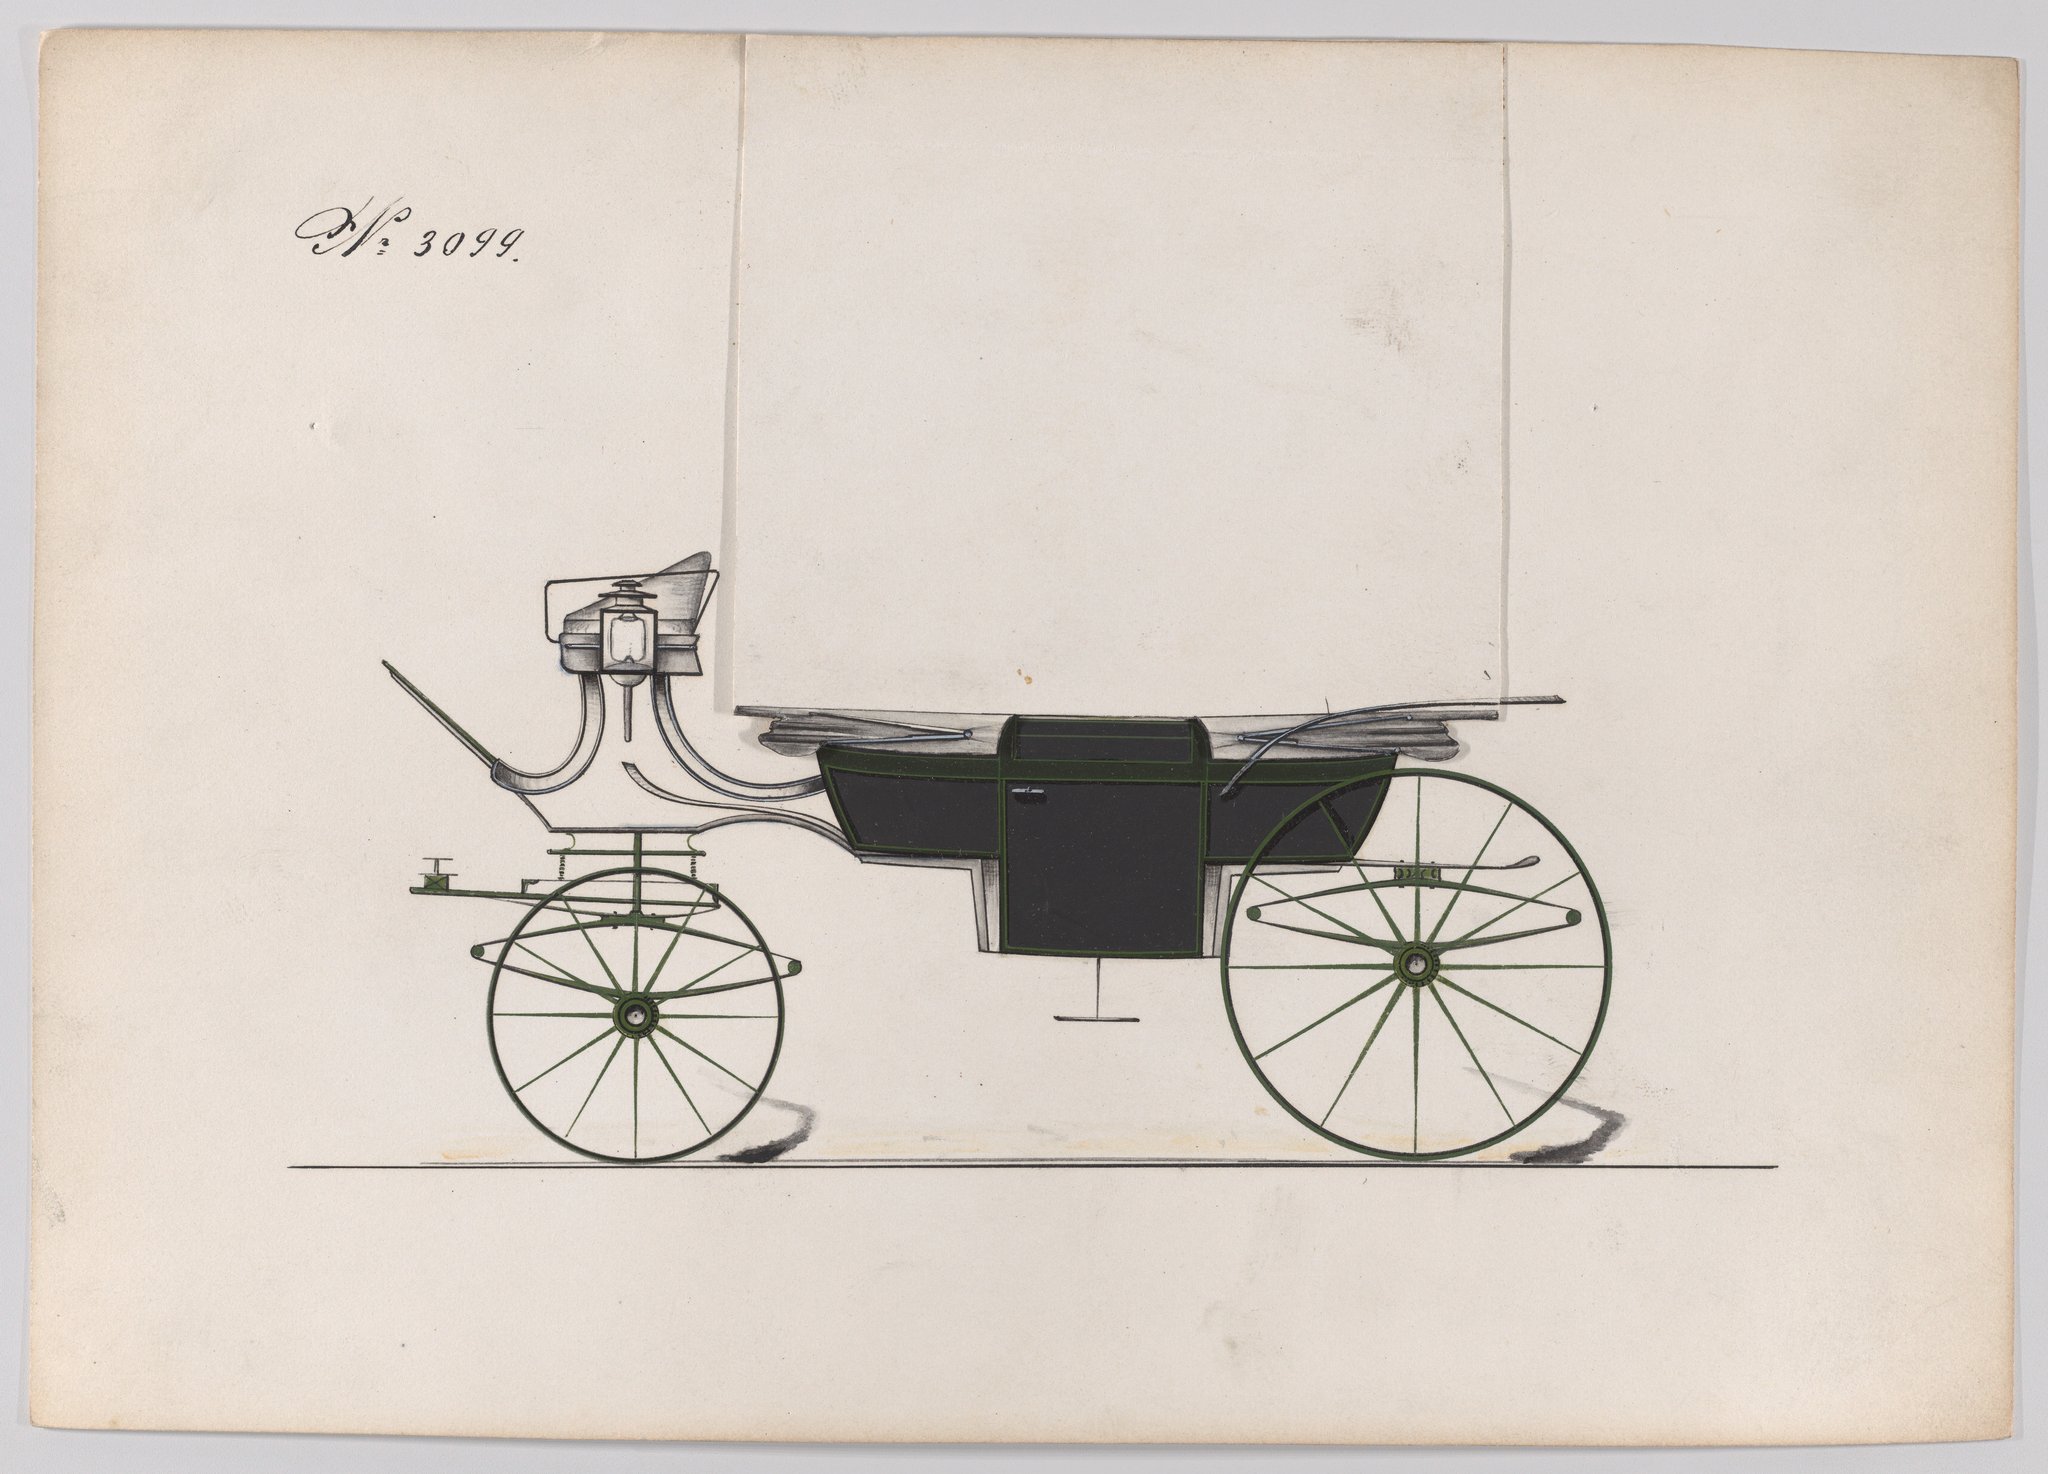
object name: drawing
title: Design for Landau, No. 3099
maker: brewster & co.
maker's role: manufacturer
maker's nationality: american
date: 1875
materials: gouache, gum arabic, ink, watercolor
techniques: pen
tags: carriages